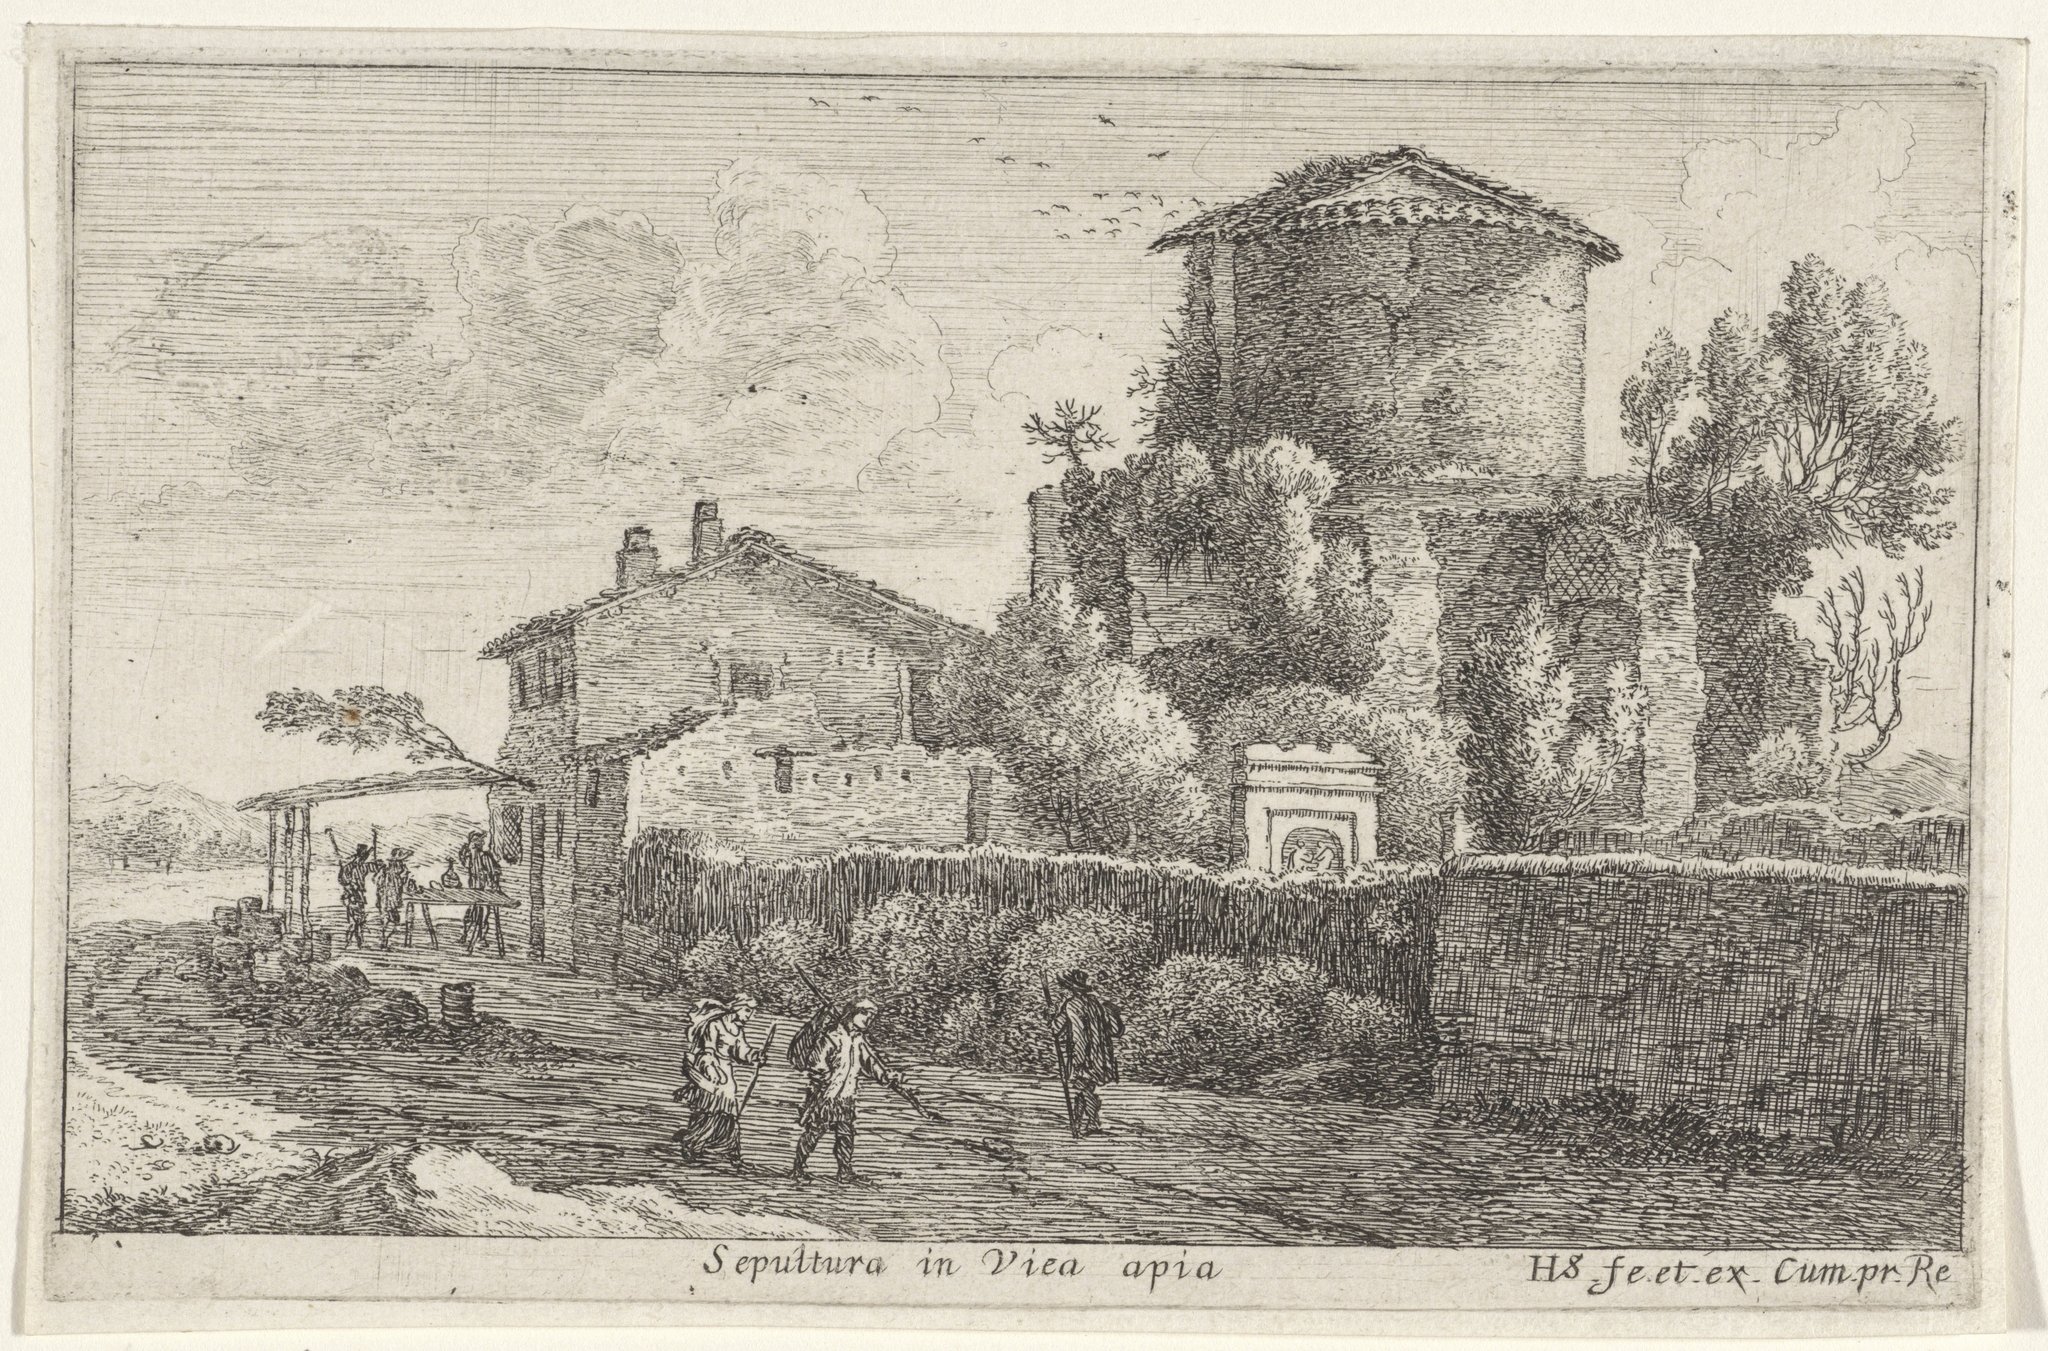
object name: print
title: Sepultura in Viea apia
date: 1652-1653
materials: paper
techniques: etching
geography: paris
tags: landscapes, rural housing, e.g. country-house, villa, cottage, grave, tomb, landscape with other man-made constructions not mentioned above, e.g.: graveyards, playgrounds, etc.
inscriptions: collector's mark: Lugt 240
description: Voor het huis naast de graftombe staan enkele figuren en drie reizigers wandelen over de Via Appia langs de ommuurde begraafplaats.